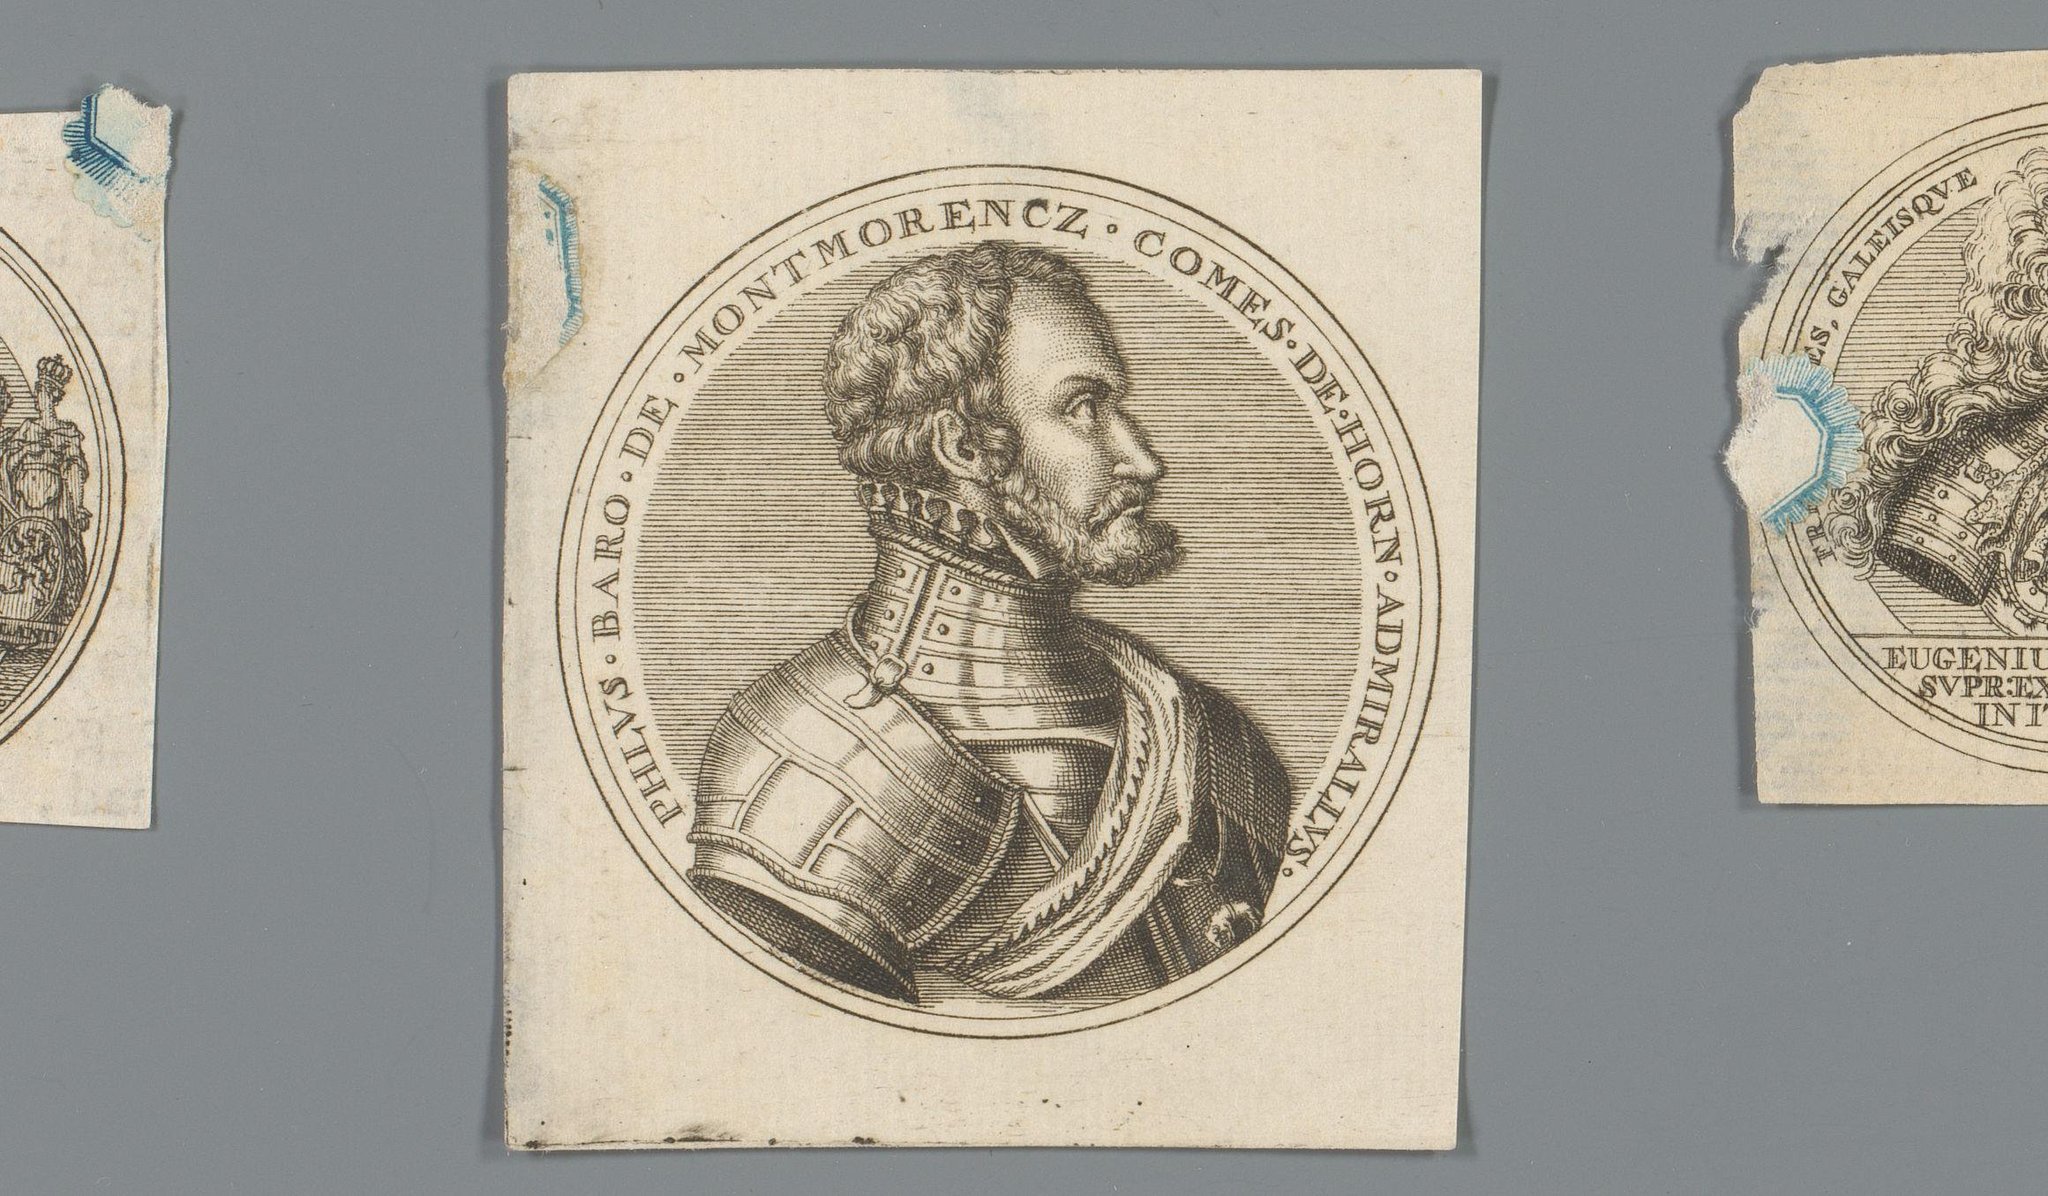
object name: book illustration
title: Voorzijde van een penning met het portret van Filips van Montmorency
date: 1723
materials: paper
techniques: etching, letterpress printing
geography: the hague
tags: brussels, commander-in-chief, general, marshal, historical persons, coin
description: Prent uit: Loon, Gerard van. Beschryving der Nederlandsche Historipenningen: (...). Den Haag: Christiaan van Lom et al., 1723, dl. 1, p. 102.